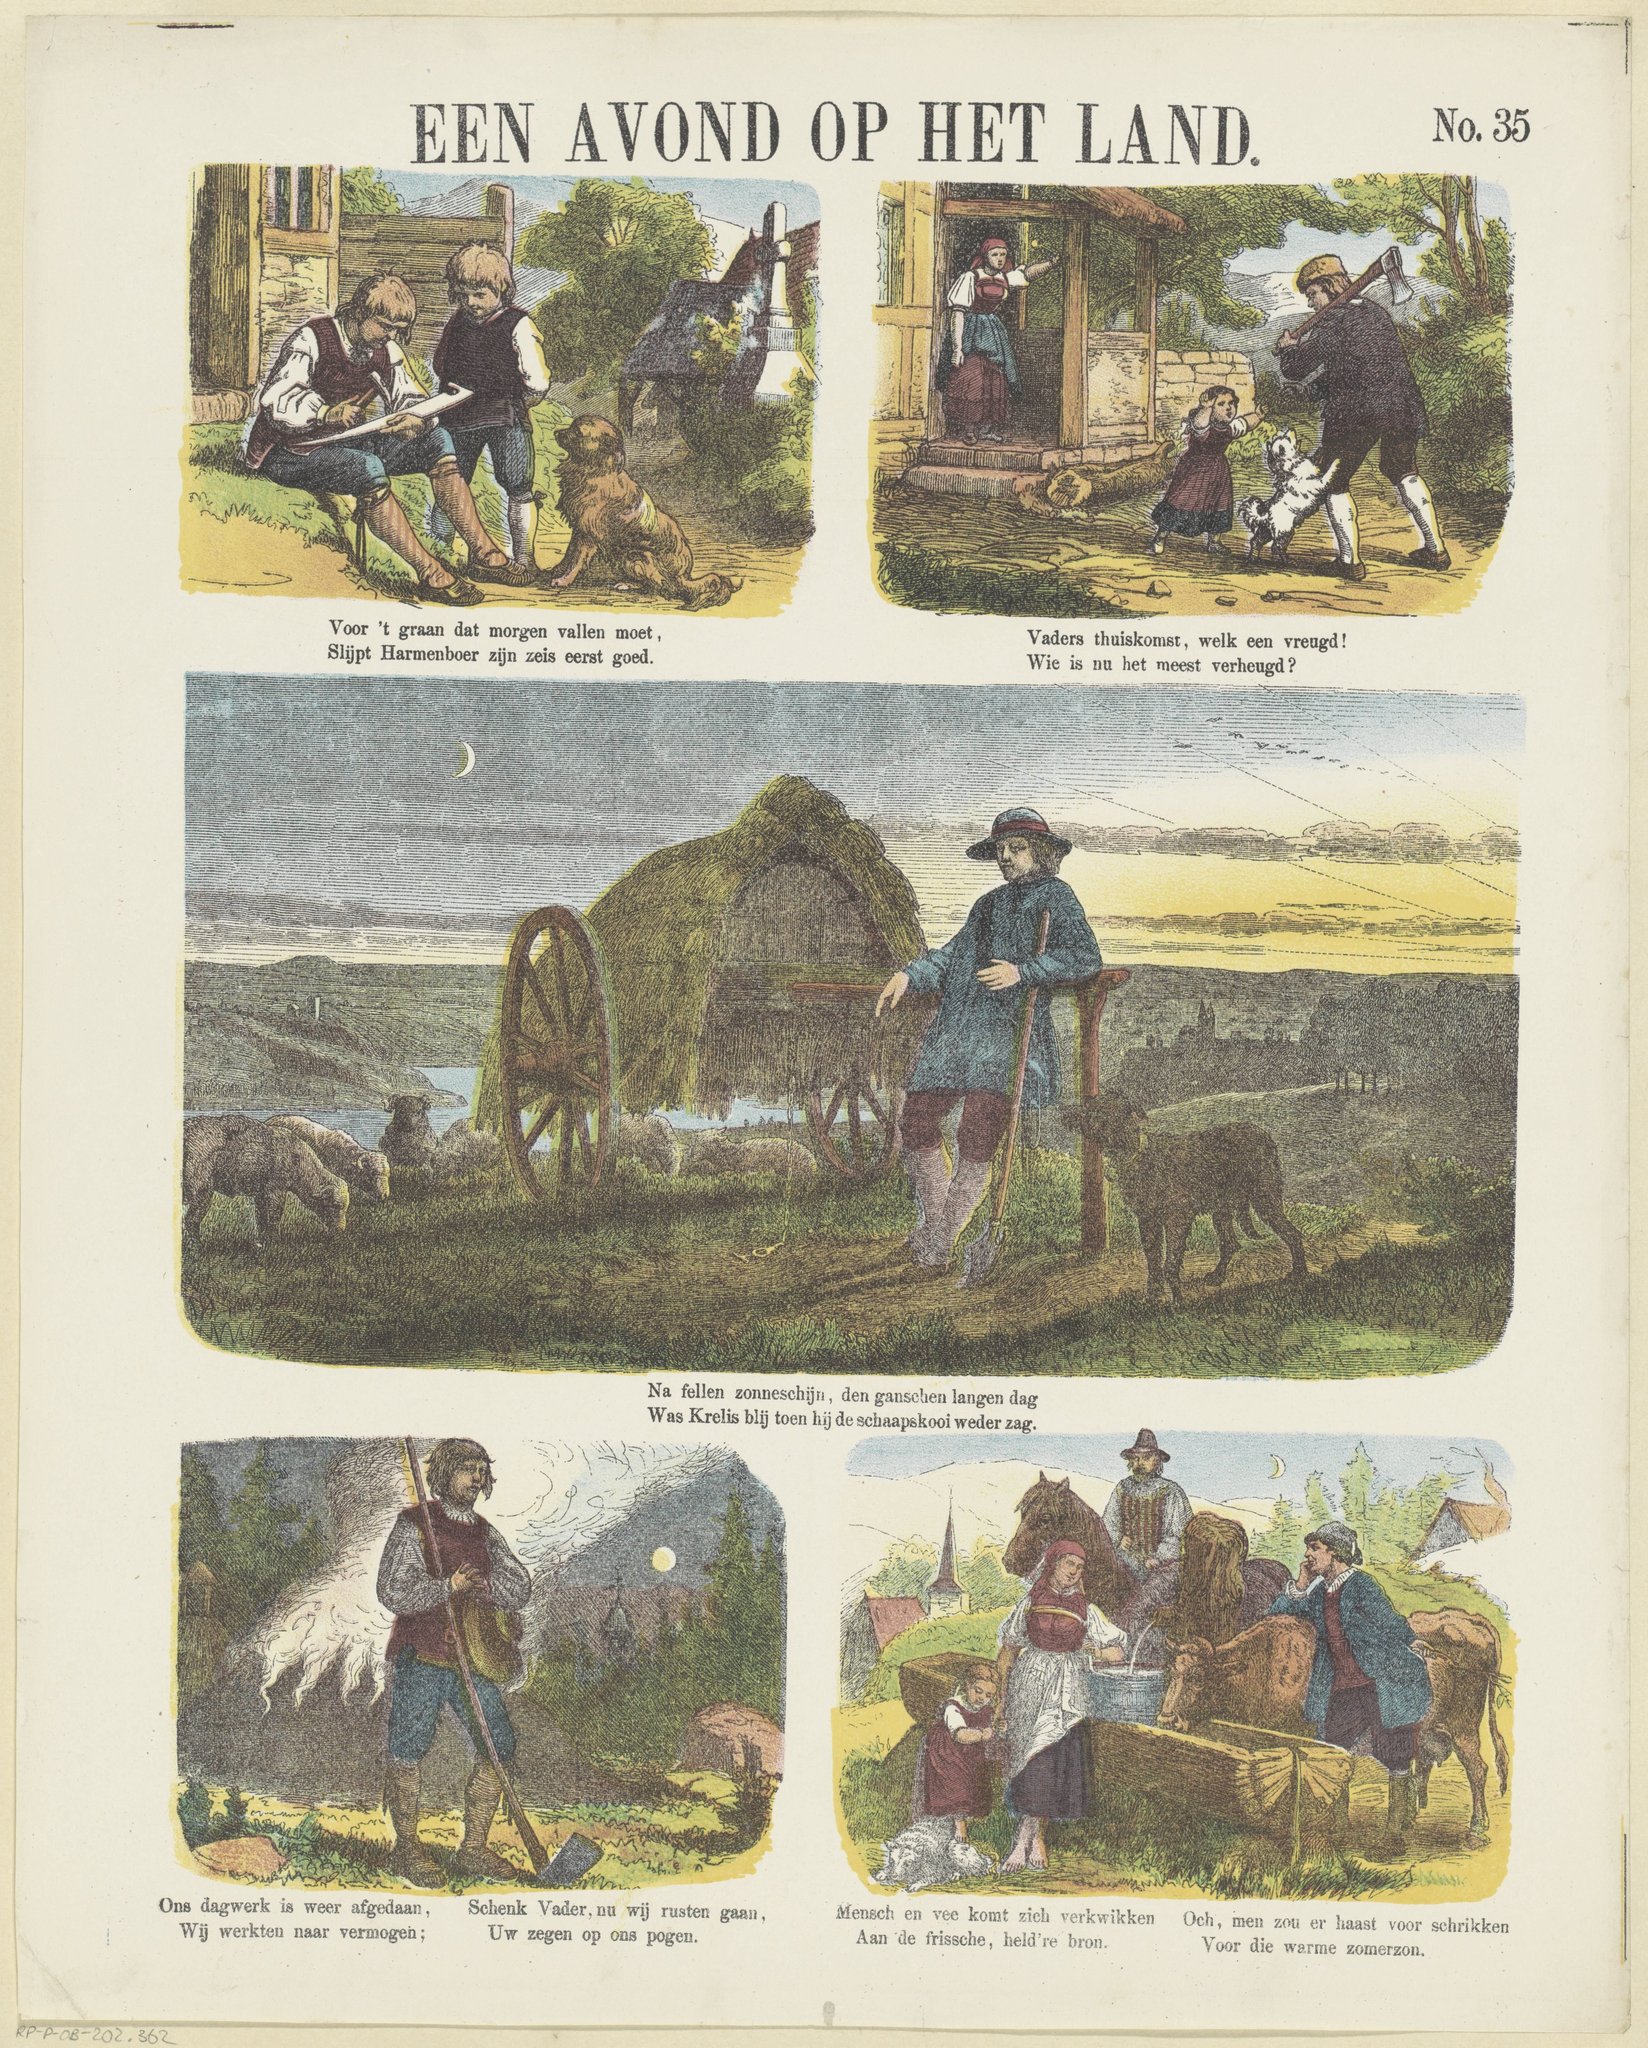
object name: print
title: Een avond op het land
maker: Anonymous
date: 1874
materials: paper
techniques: lithograph, letterpress printing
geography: amsterdam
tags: farmers, agriculture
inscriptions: collector's mark: Lugt 2760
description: Blad met 5 voorstellingen over het boerenleven en pastorale taferelen, waaronder het slijpen van de zeis, vaders thuiskomst, een schaapherder, een biddende landman en dieren aan de drinkbak. Onder elke afbeelding een vers. Genummerd rechtsboven: No. 35.